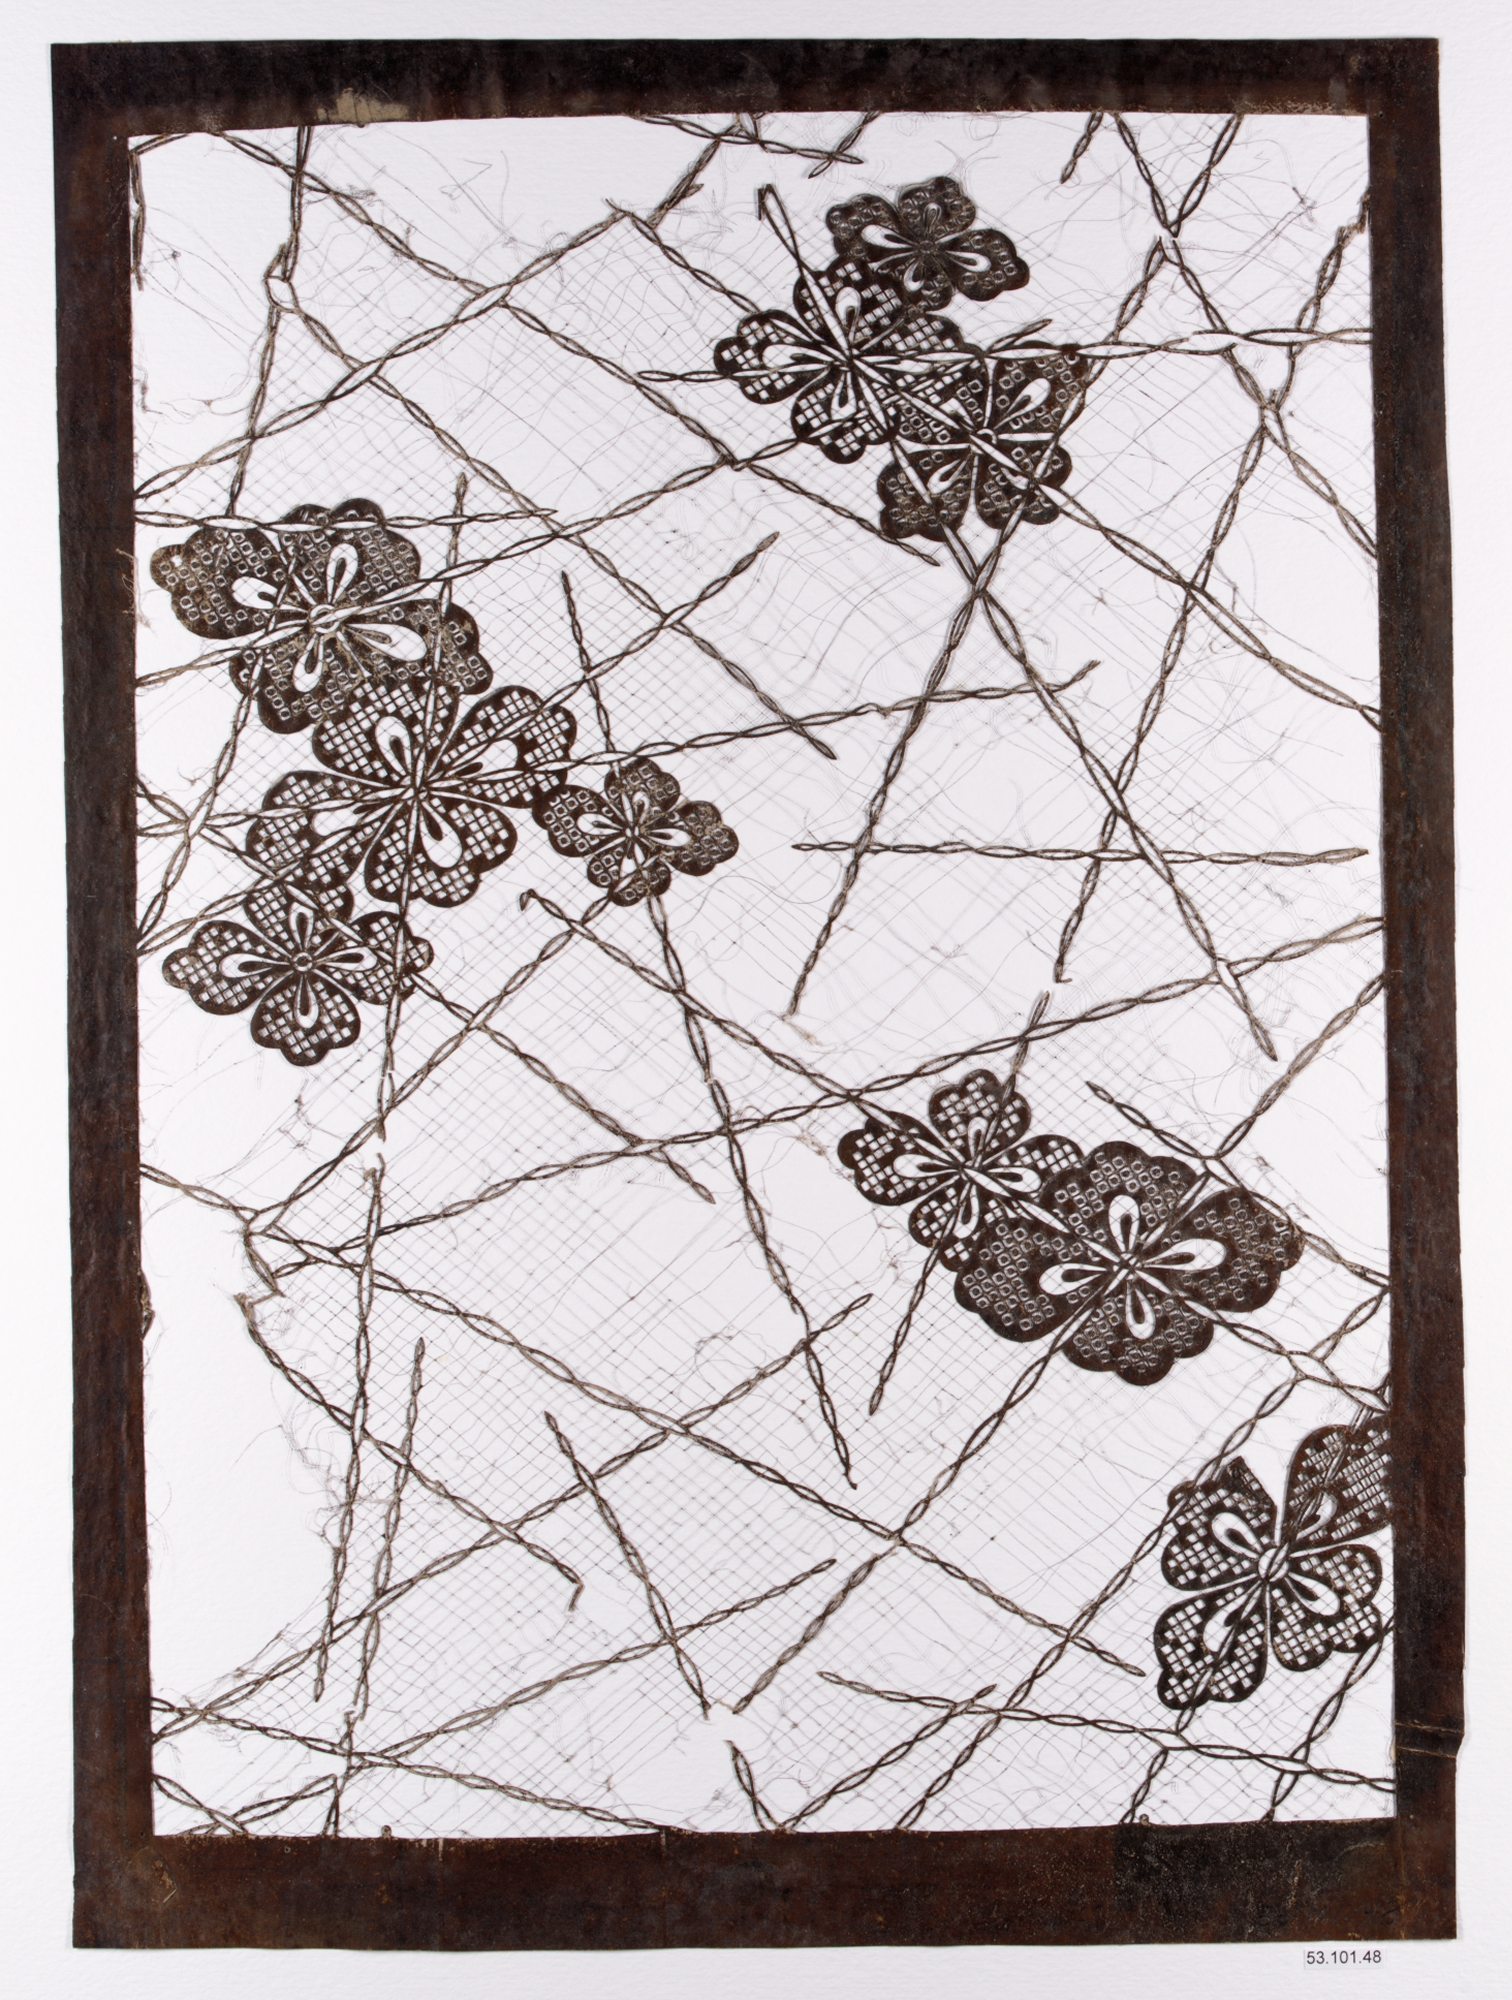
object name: stencil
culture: japanese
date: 1615-1868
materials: paper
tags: flowers